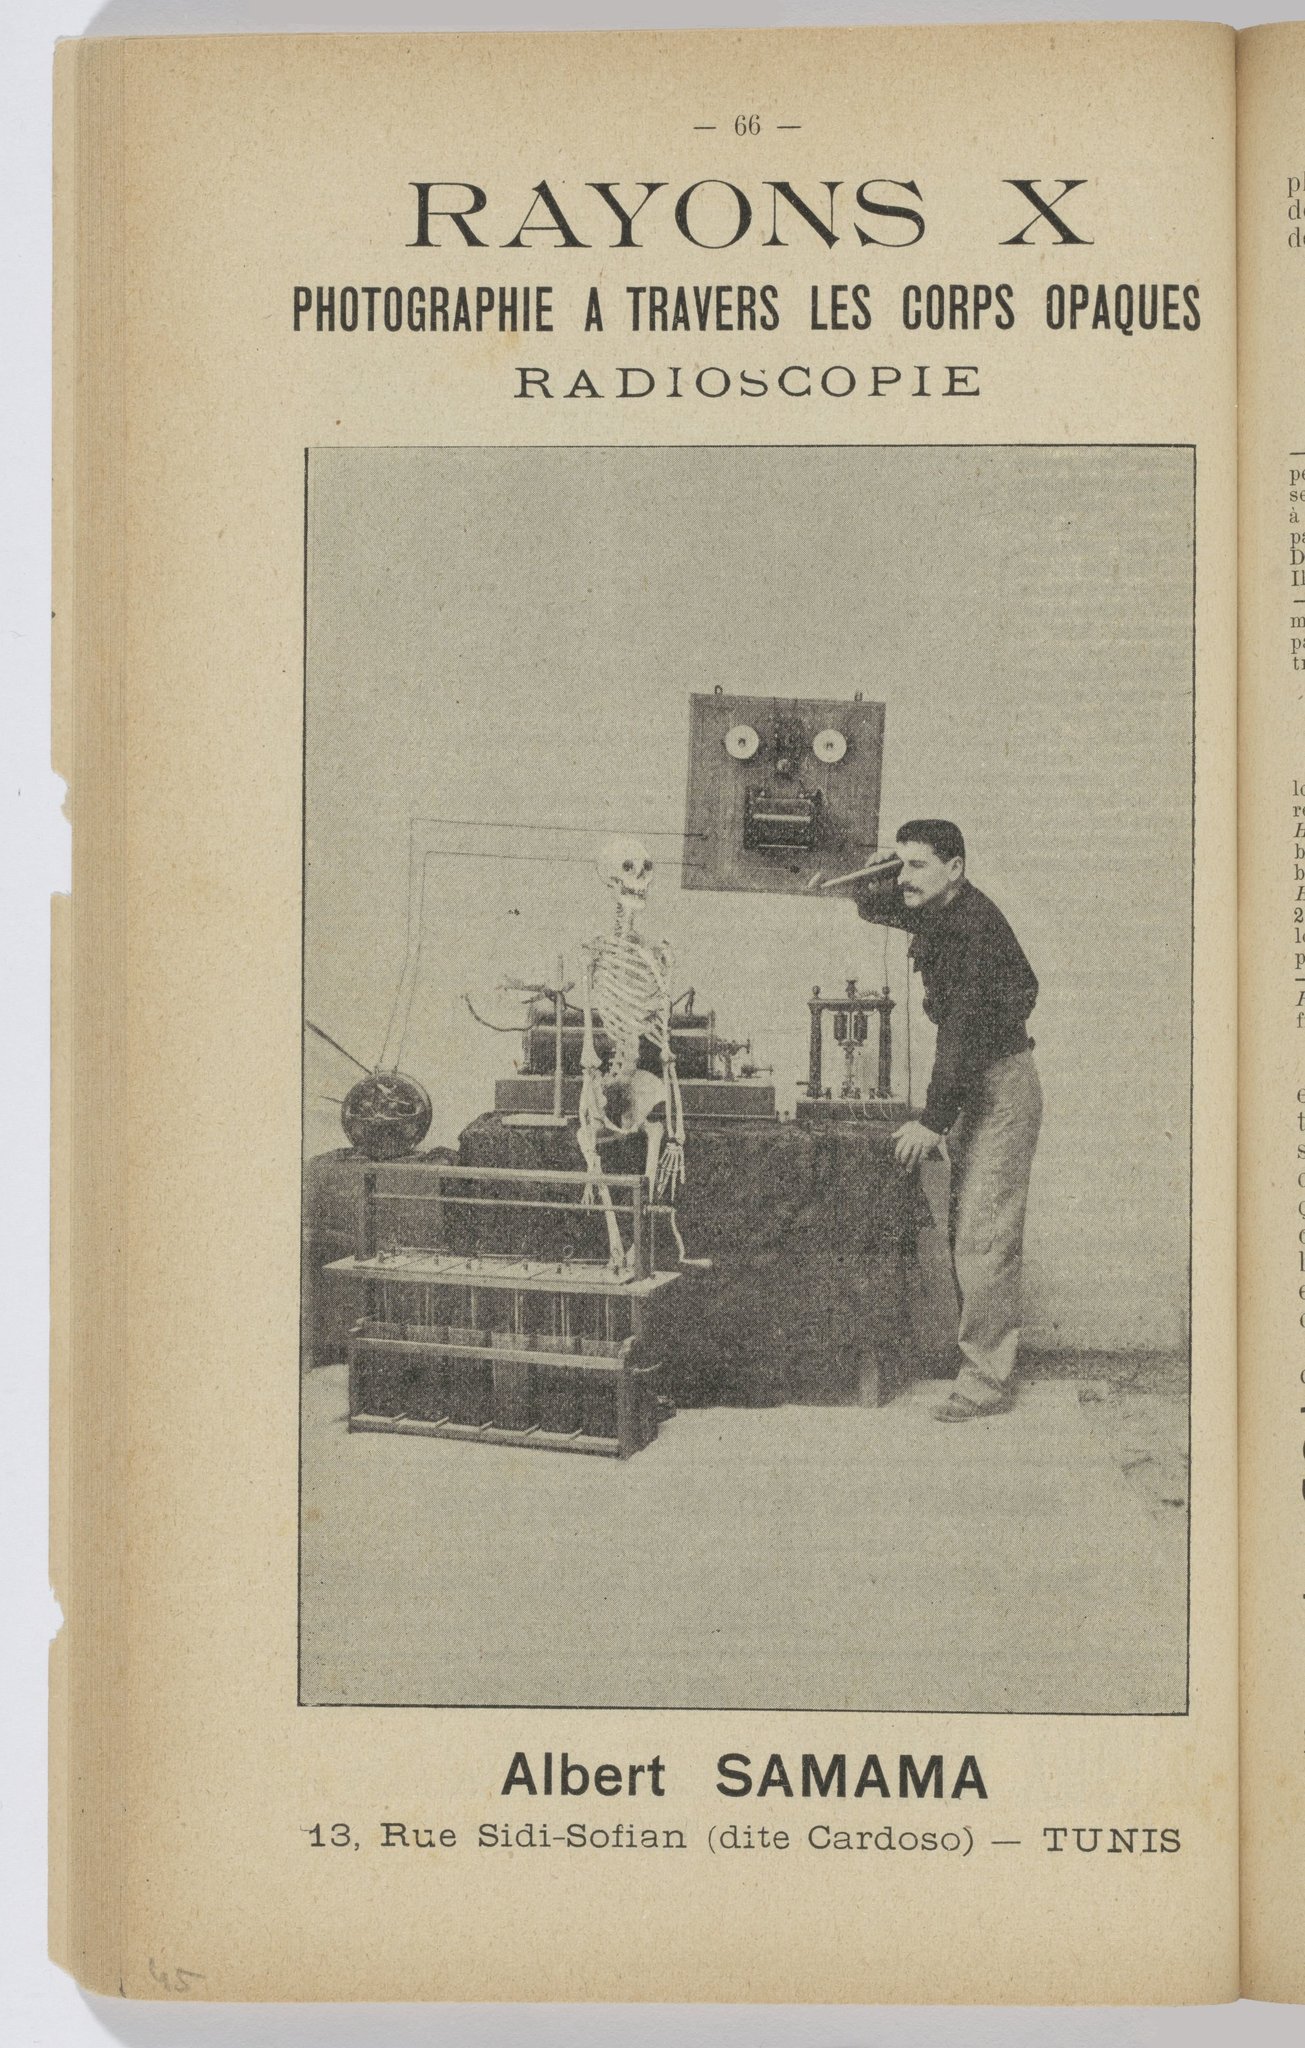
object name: photomechanical print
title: Albert Samama bekijkt een skelet met een röntgentoestel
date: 1895-1898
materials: paper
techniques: autotype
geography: tunis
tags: albert samama, x-ray examination, (human) skeleton, photographer at work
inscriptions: inscription: ‘Rayons X photographie a travers les corps opaques radioscopie’, inscription: ‘Albert Samama 13, Rue Sidi-Sofian (dite Cardoso) - Tunis’